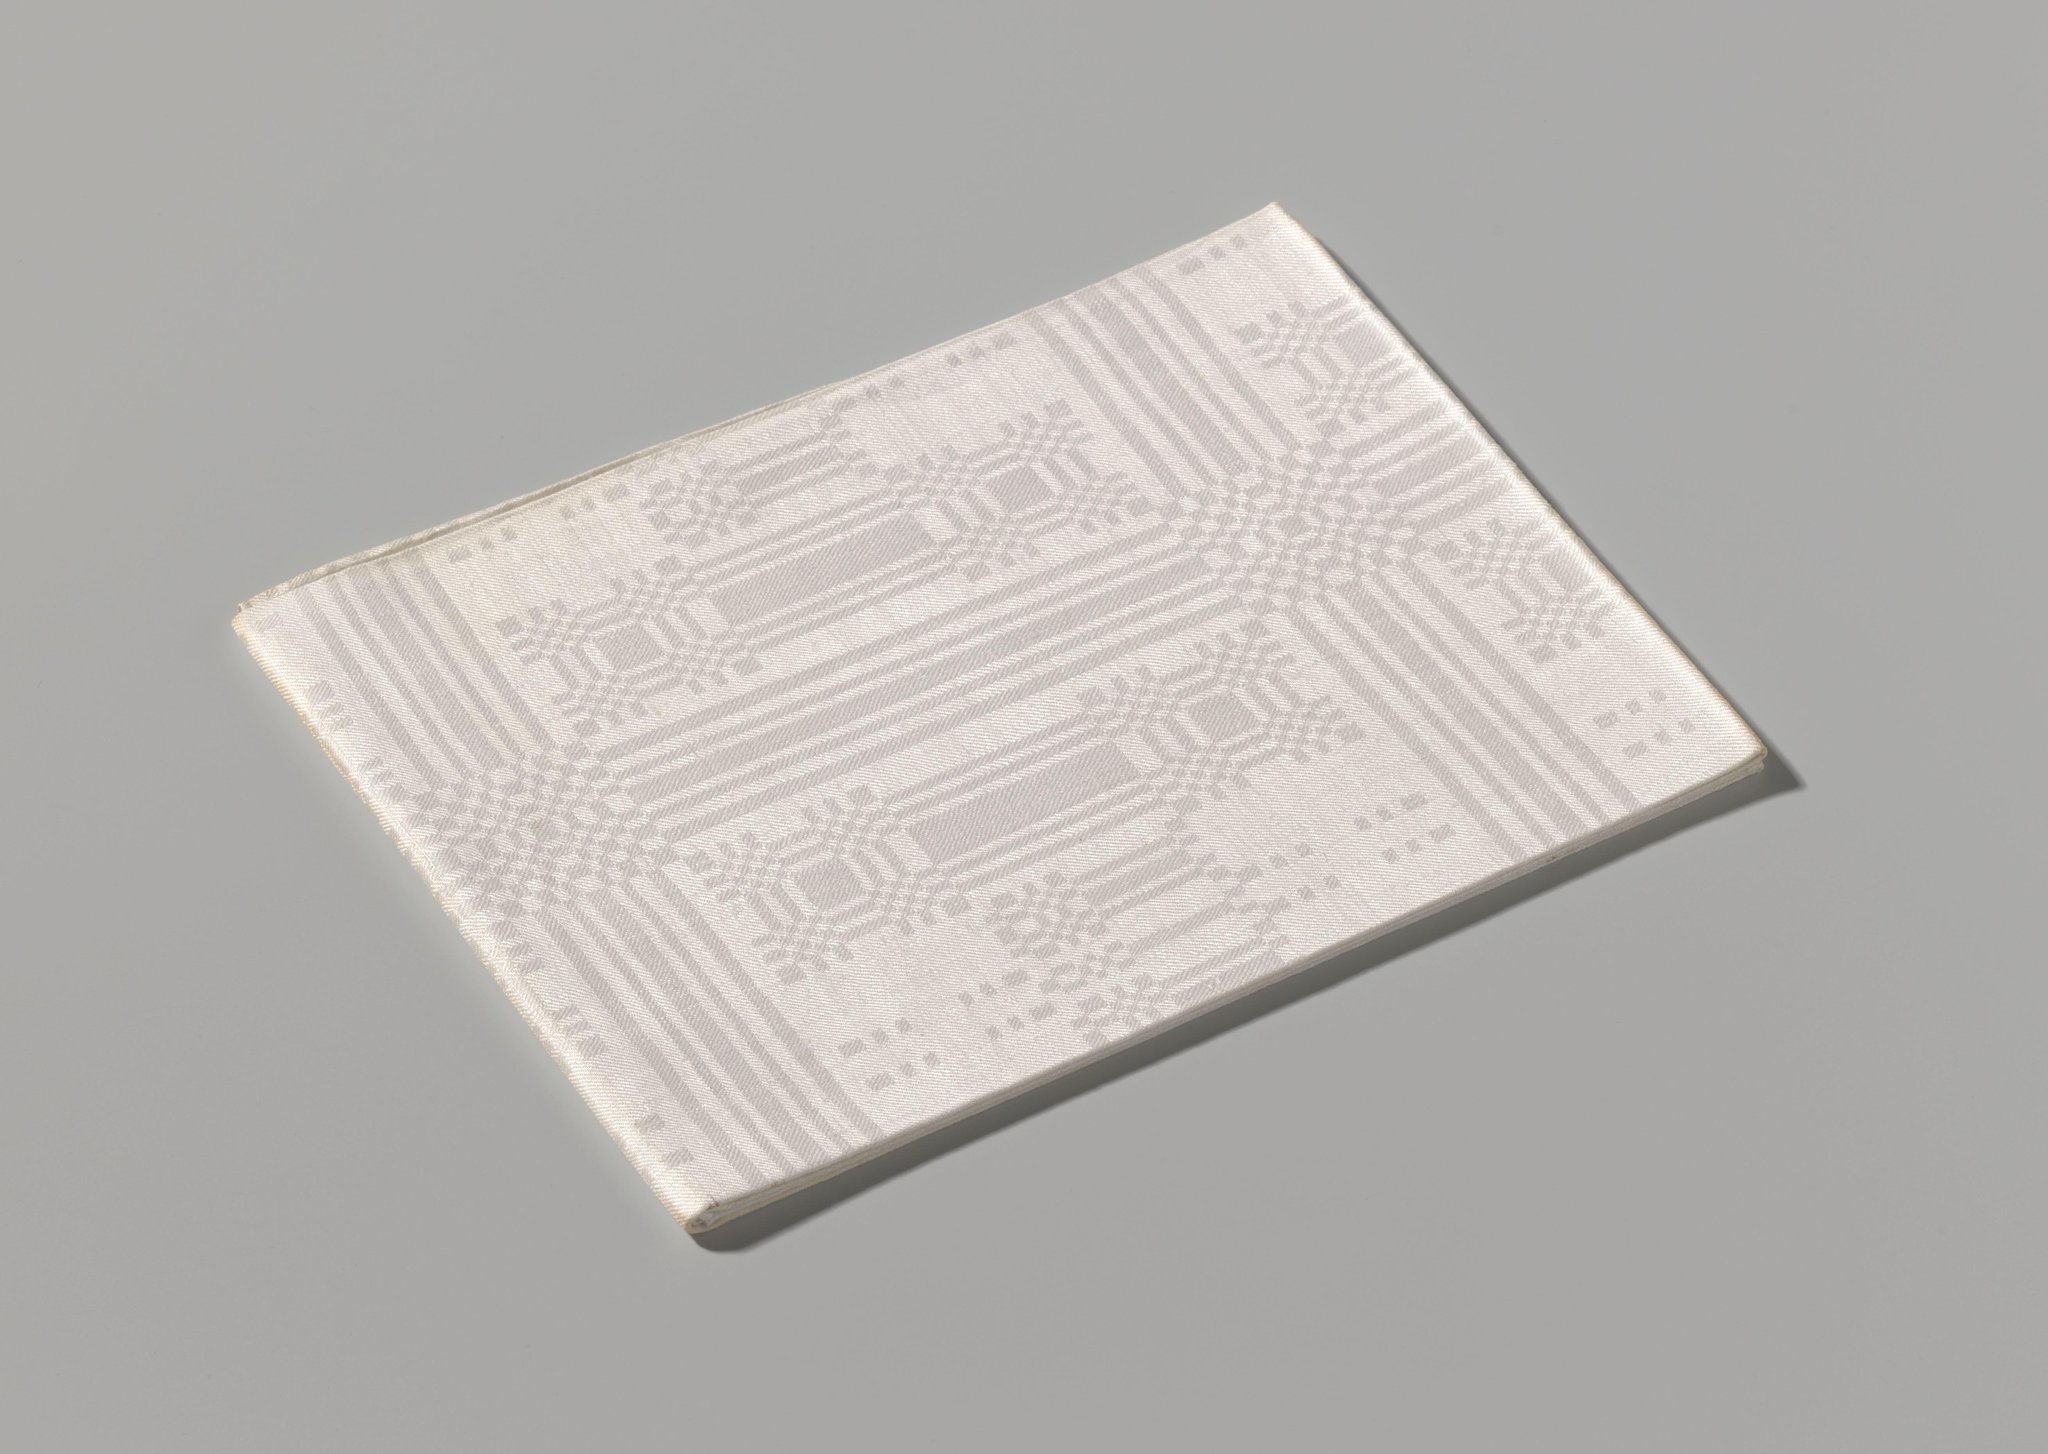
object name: napkin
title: Servet van linnen met pellenpatroon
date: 1740-1786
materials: linen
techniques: twill, peeled fabric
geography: northern netherlands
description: wit linnen servet met pellen patroon, merk kroon IAVG 36